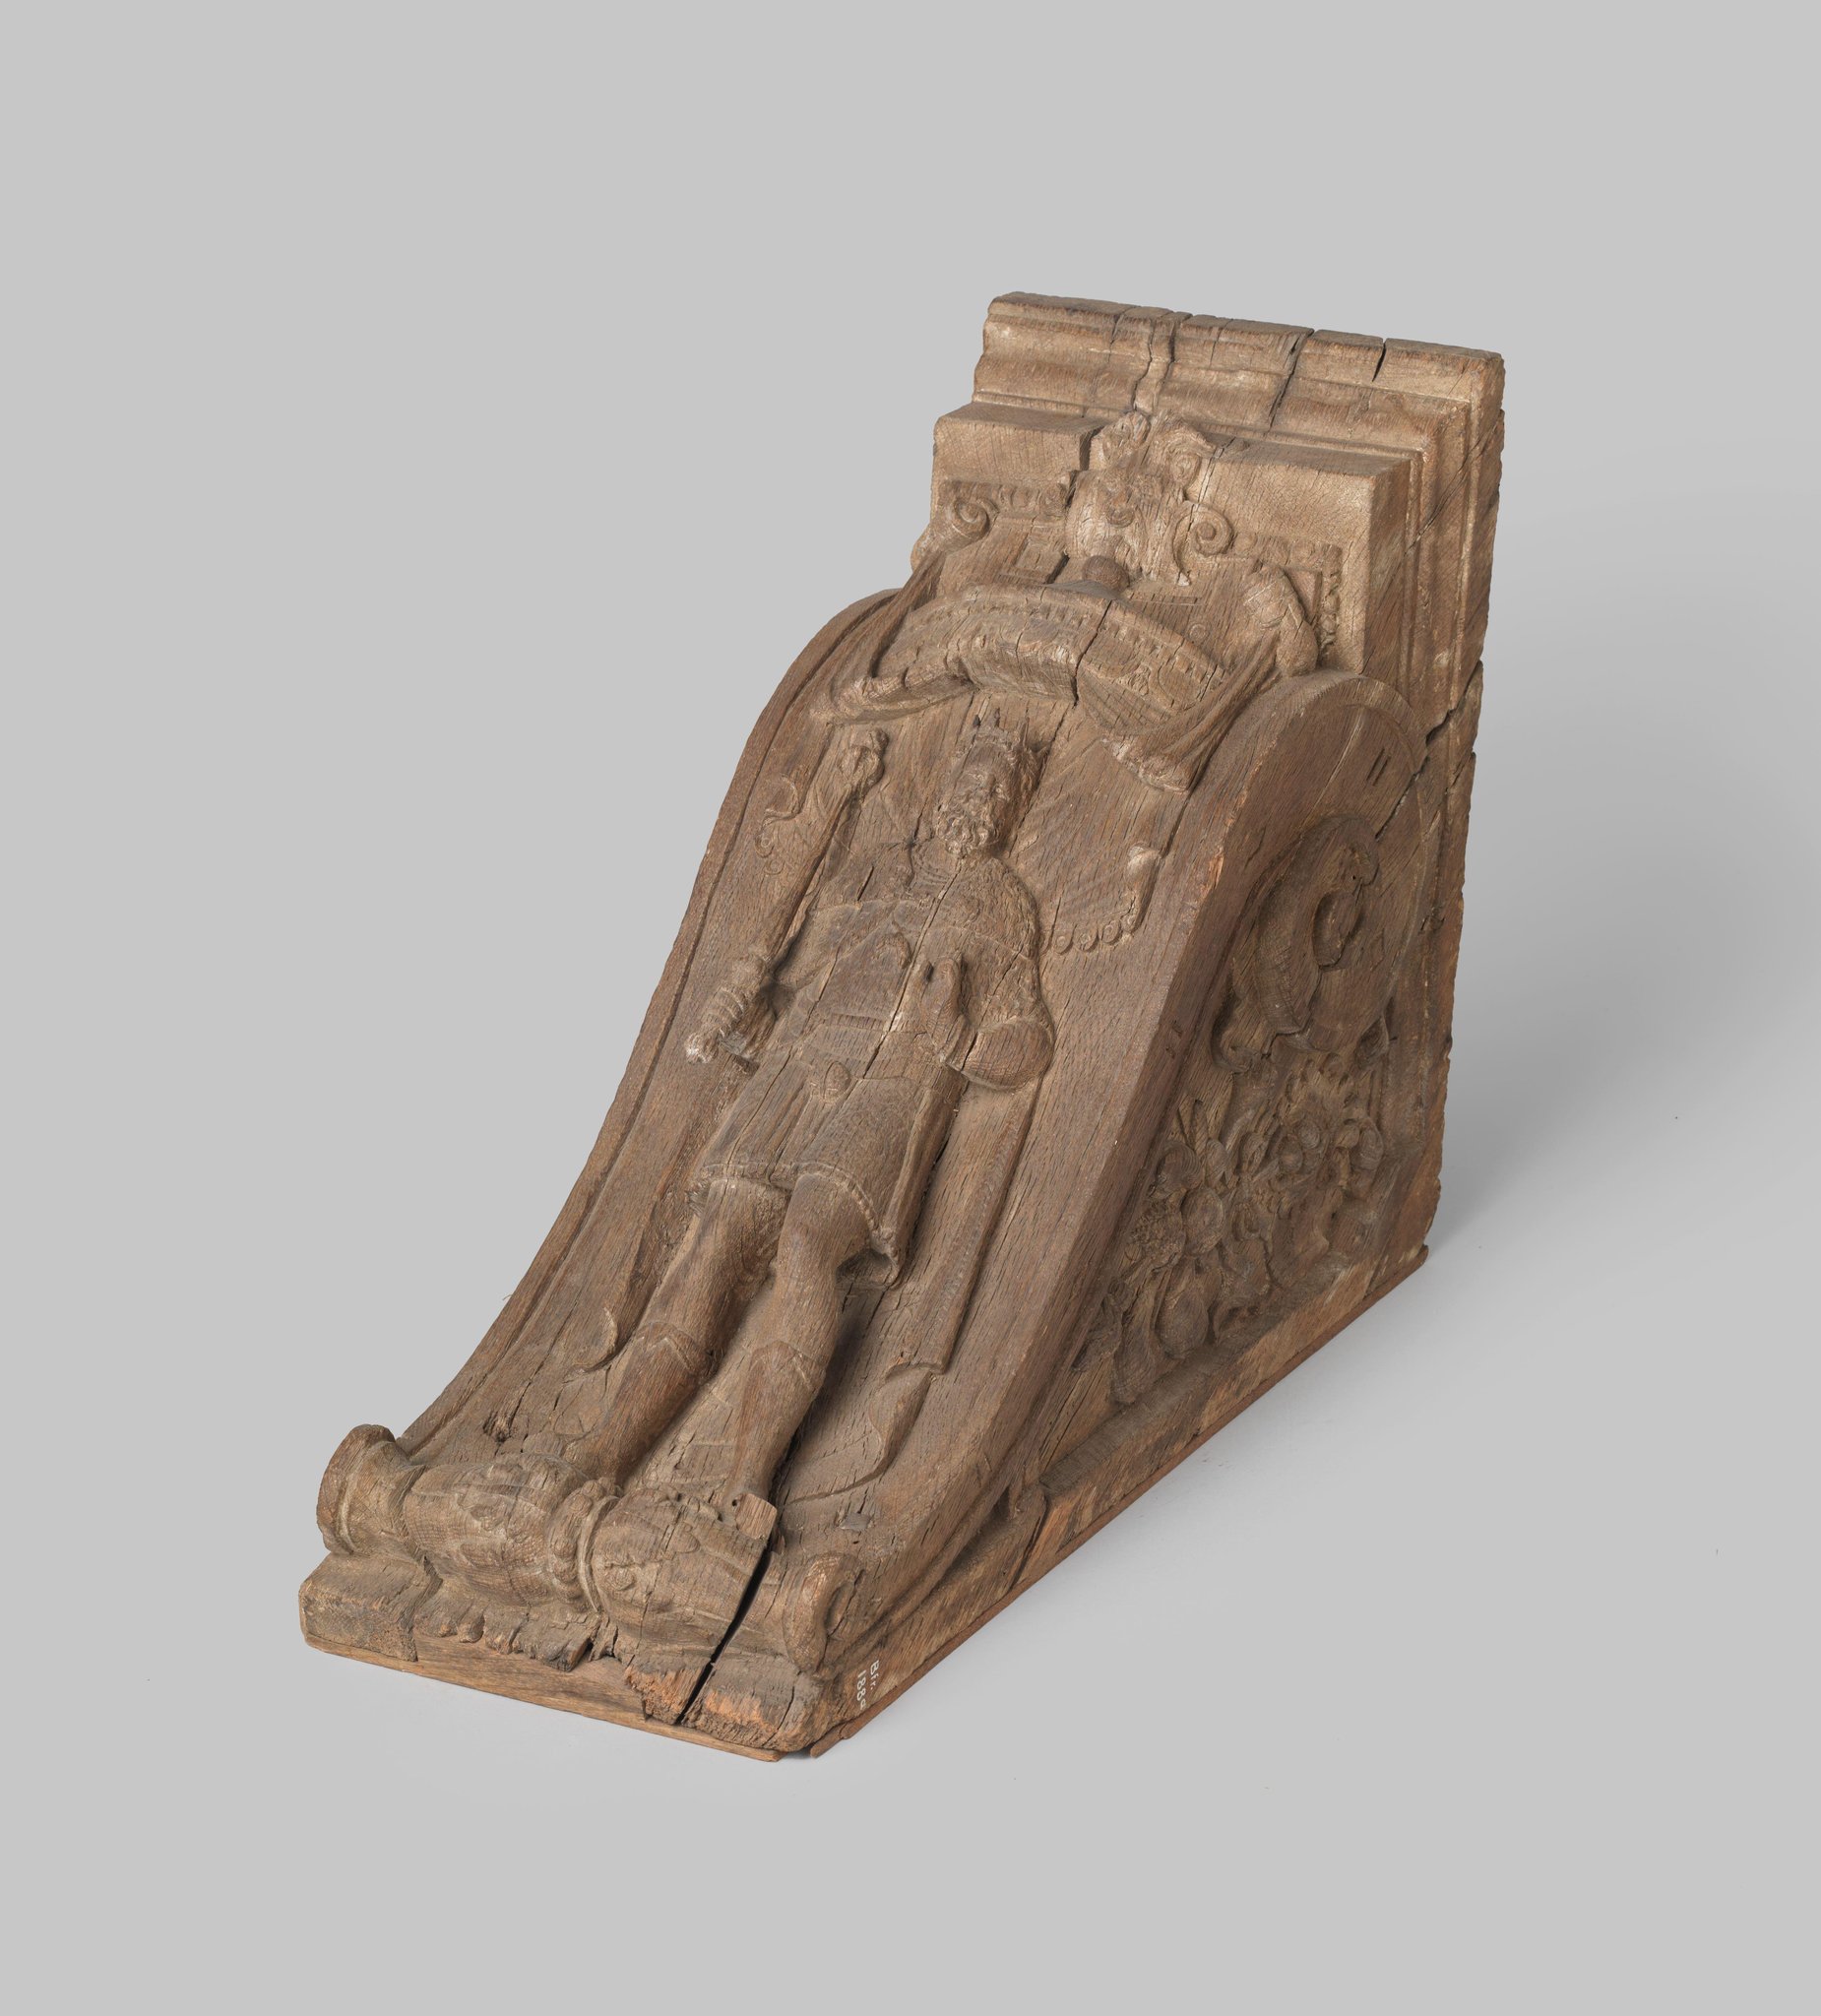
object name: korbeel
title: Korbeel met gesneden voorstelling van een gekroonde keurvorst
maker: Anonymous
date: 1550-1600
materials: wood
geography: northern netherlands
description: Korbeel van eikenhout met een gesneden voorstelling van een gekroonde keurvorst staande onder een baldakijn. Afkomstig uit het afgebroken huis Warmoesstraat 145 te Amsterdam.